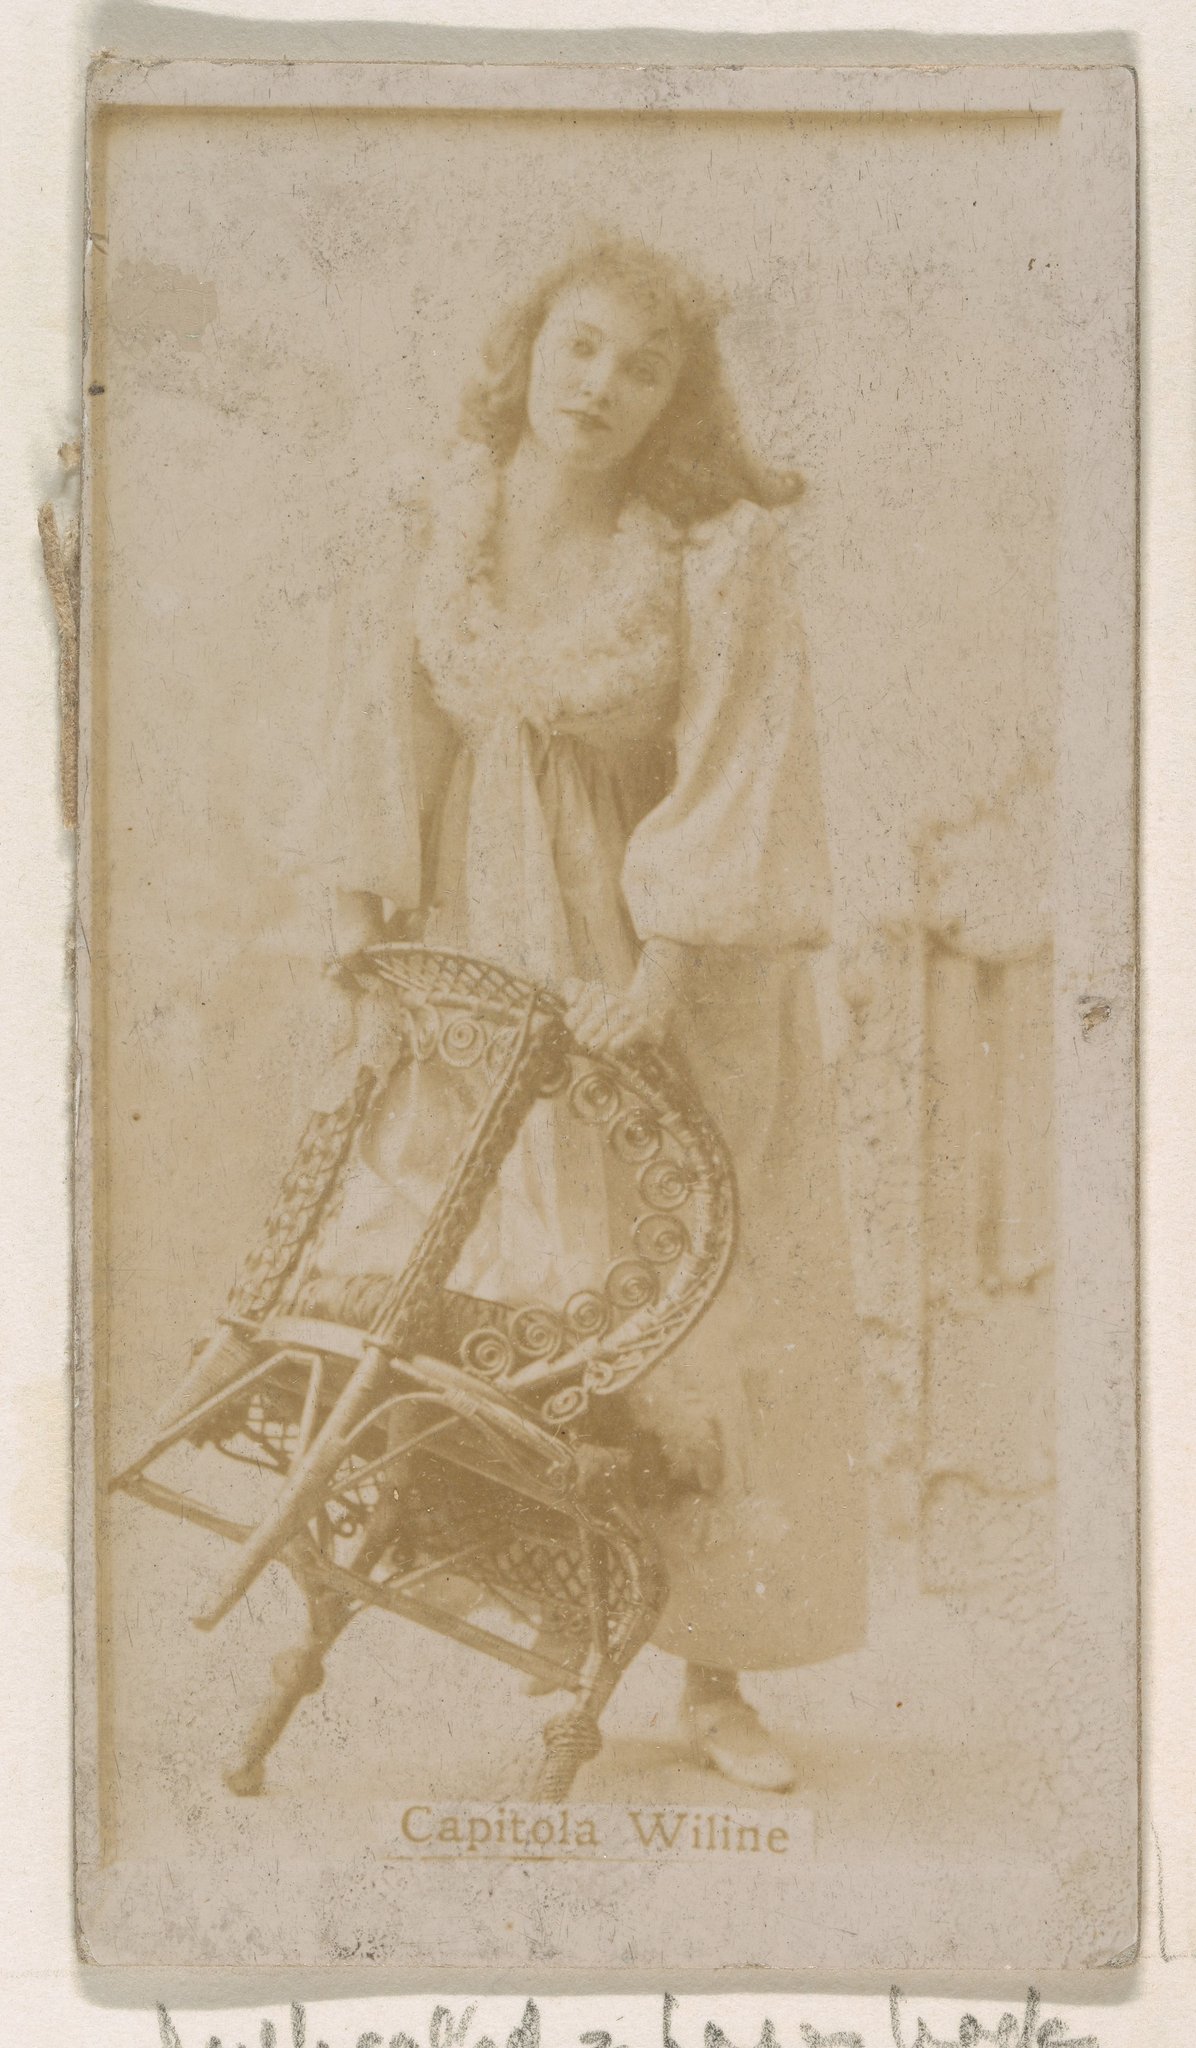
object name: photograph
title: Capitola Wiline, from the Actresses series (N245) issued by Kinney Brothers to promote Sweet Caporal Cigarettes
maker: kinney brothers tobacco company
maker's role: publisher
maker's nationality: american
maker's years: 1869-2011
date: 1890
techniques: albumen silver print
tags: portraits,women,actresses